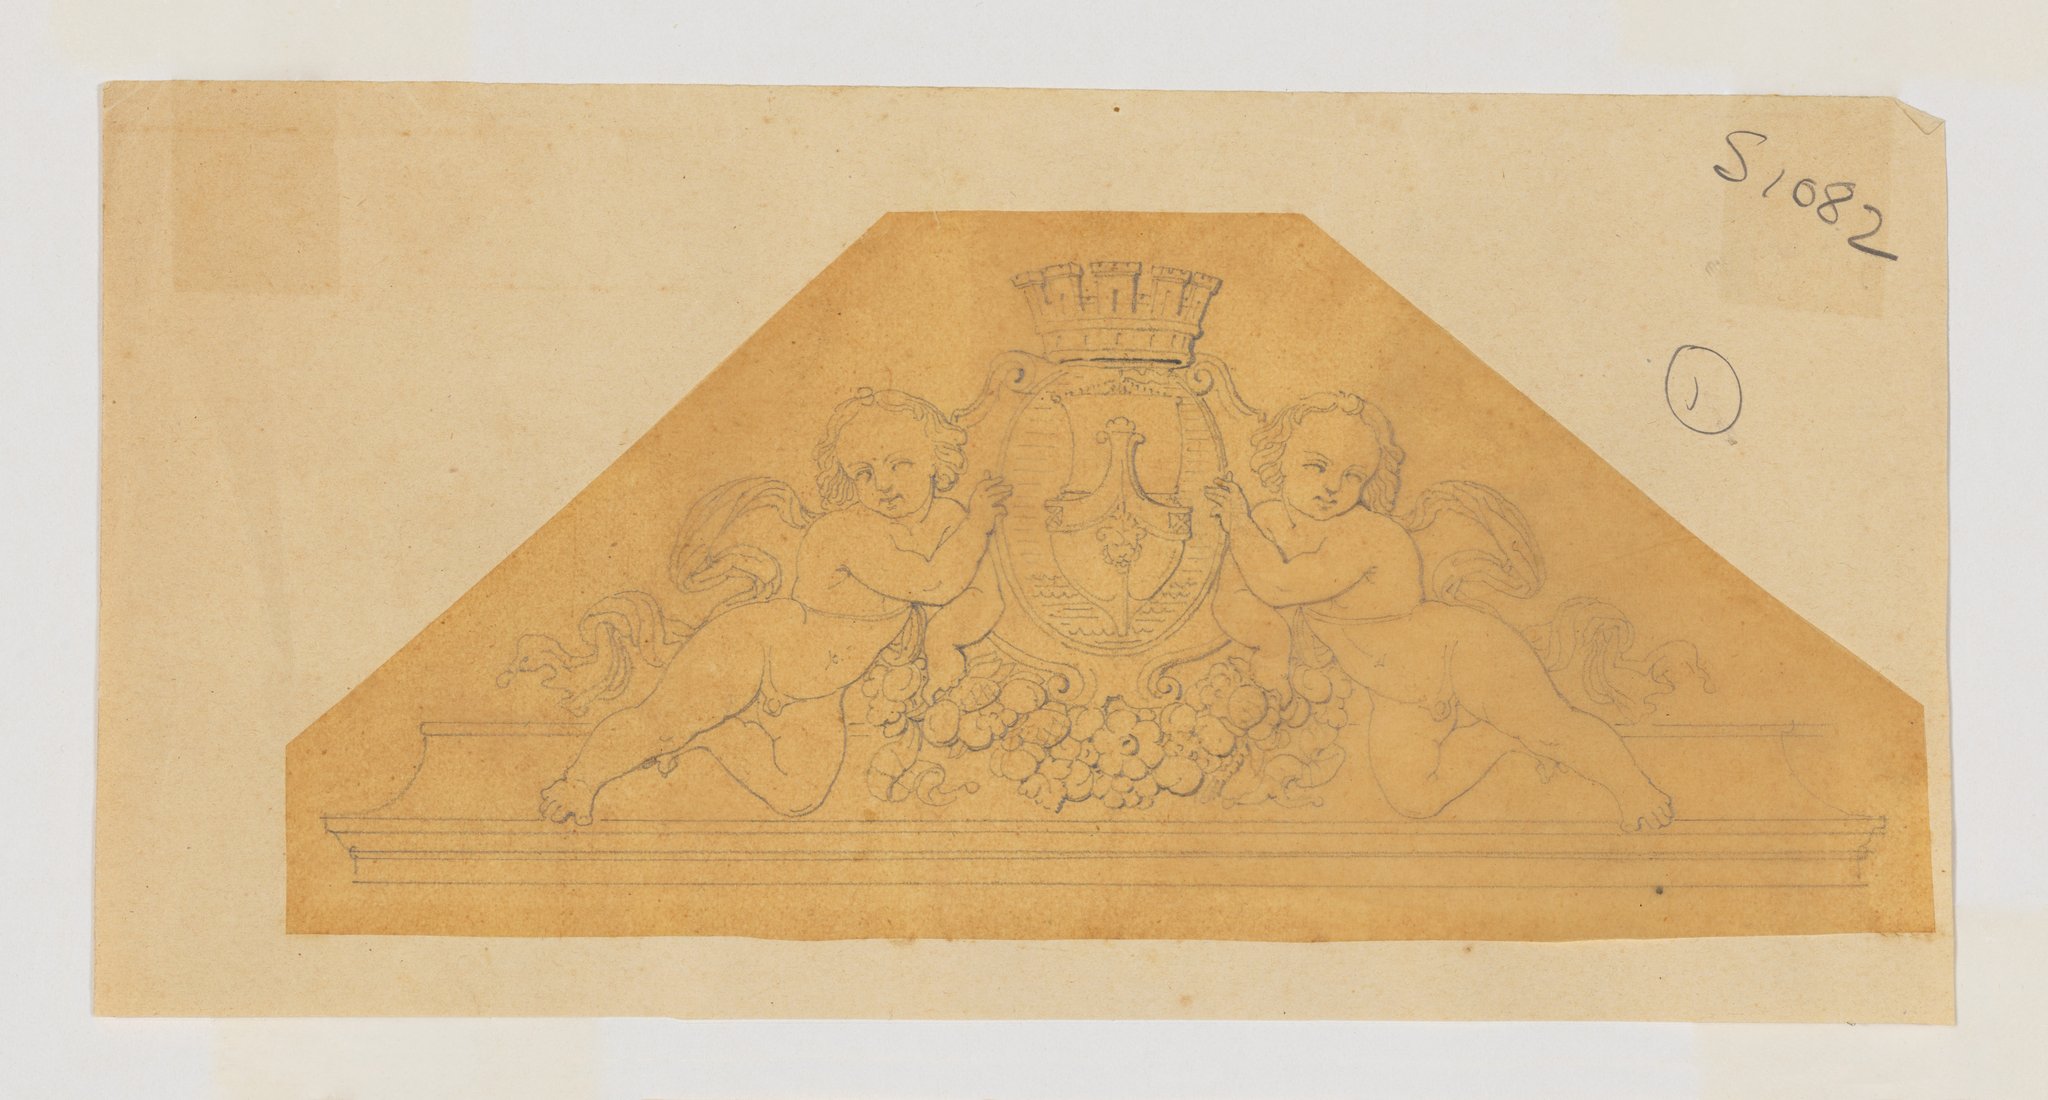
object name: drawing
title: Design for an Overdoor with Two Mirroring Putti flanking a Coat of Arms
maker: jean-baptiste louis plantar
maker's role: artist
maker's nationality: french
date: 1834-1866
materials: graphite, ink, watercolor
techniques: pen